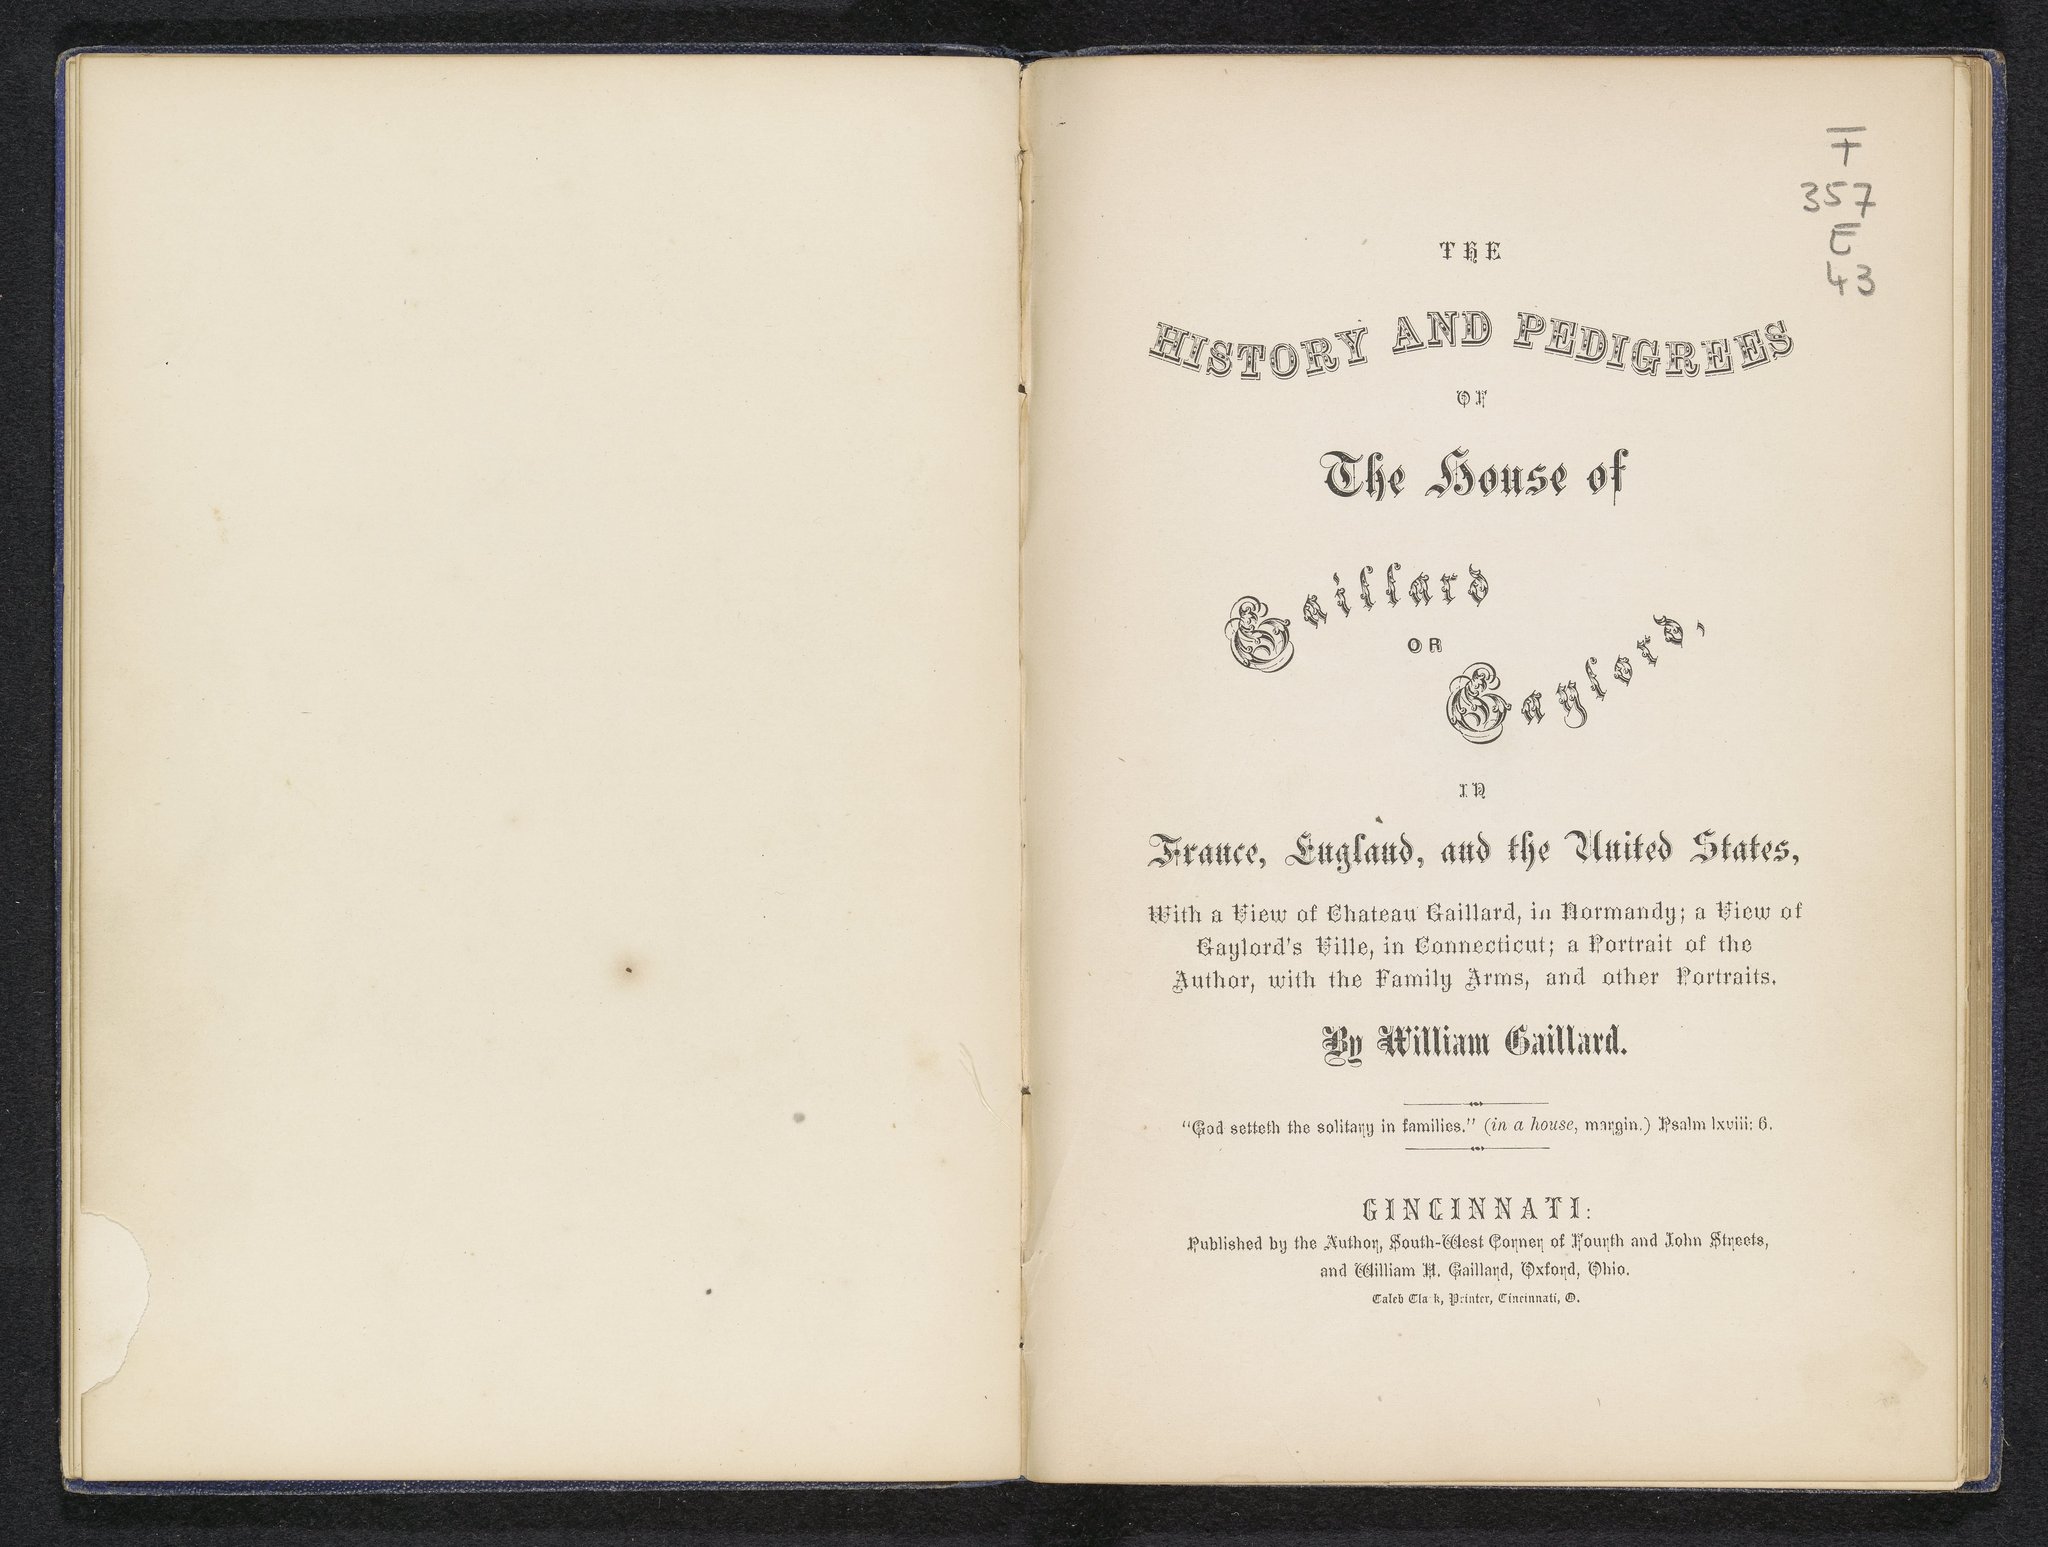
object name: book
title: The history and pedigrees of the house of Gaillard or Gaylord, in France, England, and the United States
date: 1870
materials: cardboard, linen, paper, photographic support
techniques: albumen print, printing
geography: cincinnati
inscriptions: inscription: ‘Cora Gaylord Ryan 413 [...] N.Y.’